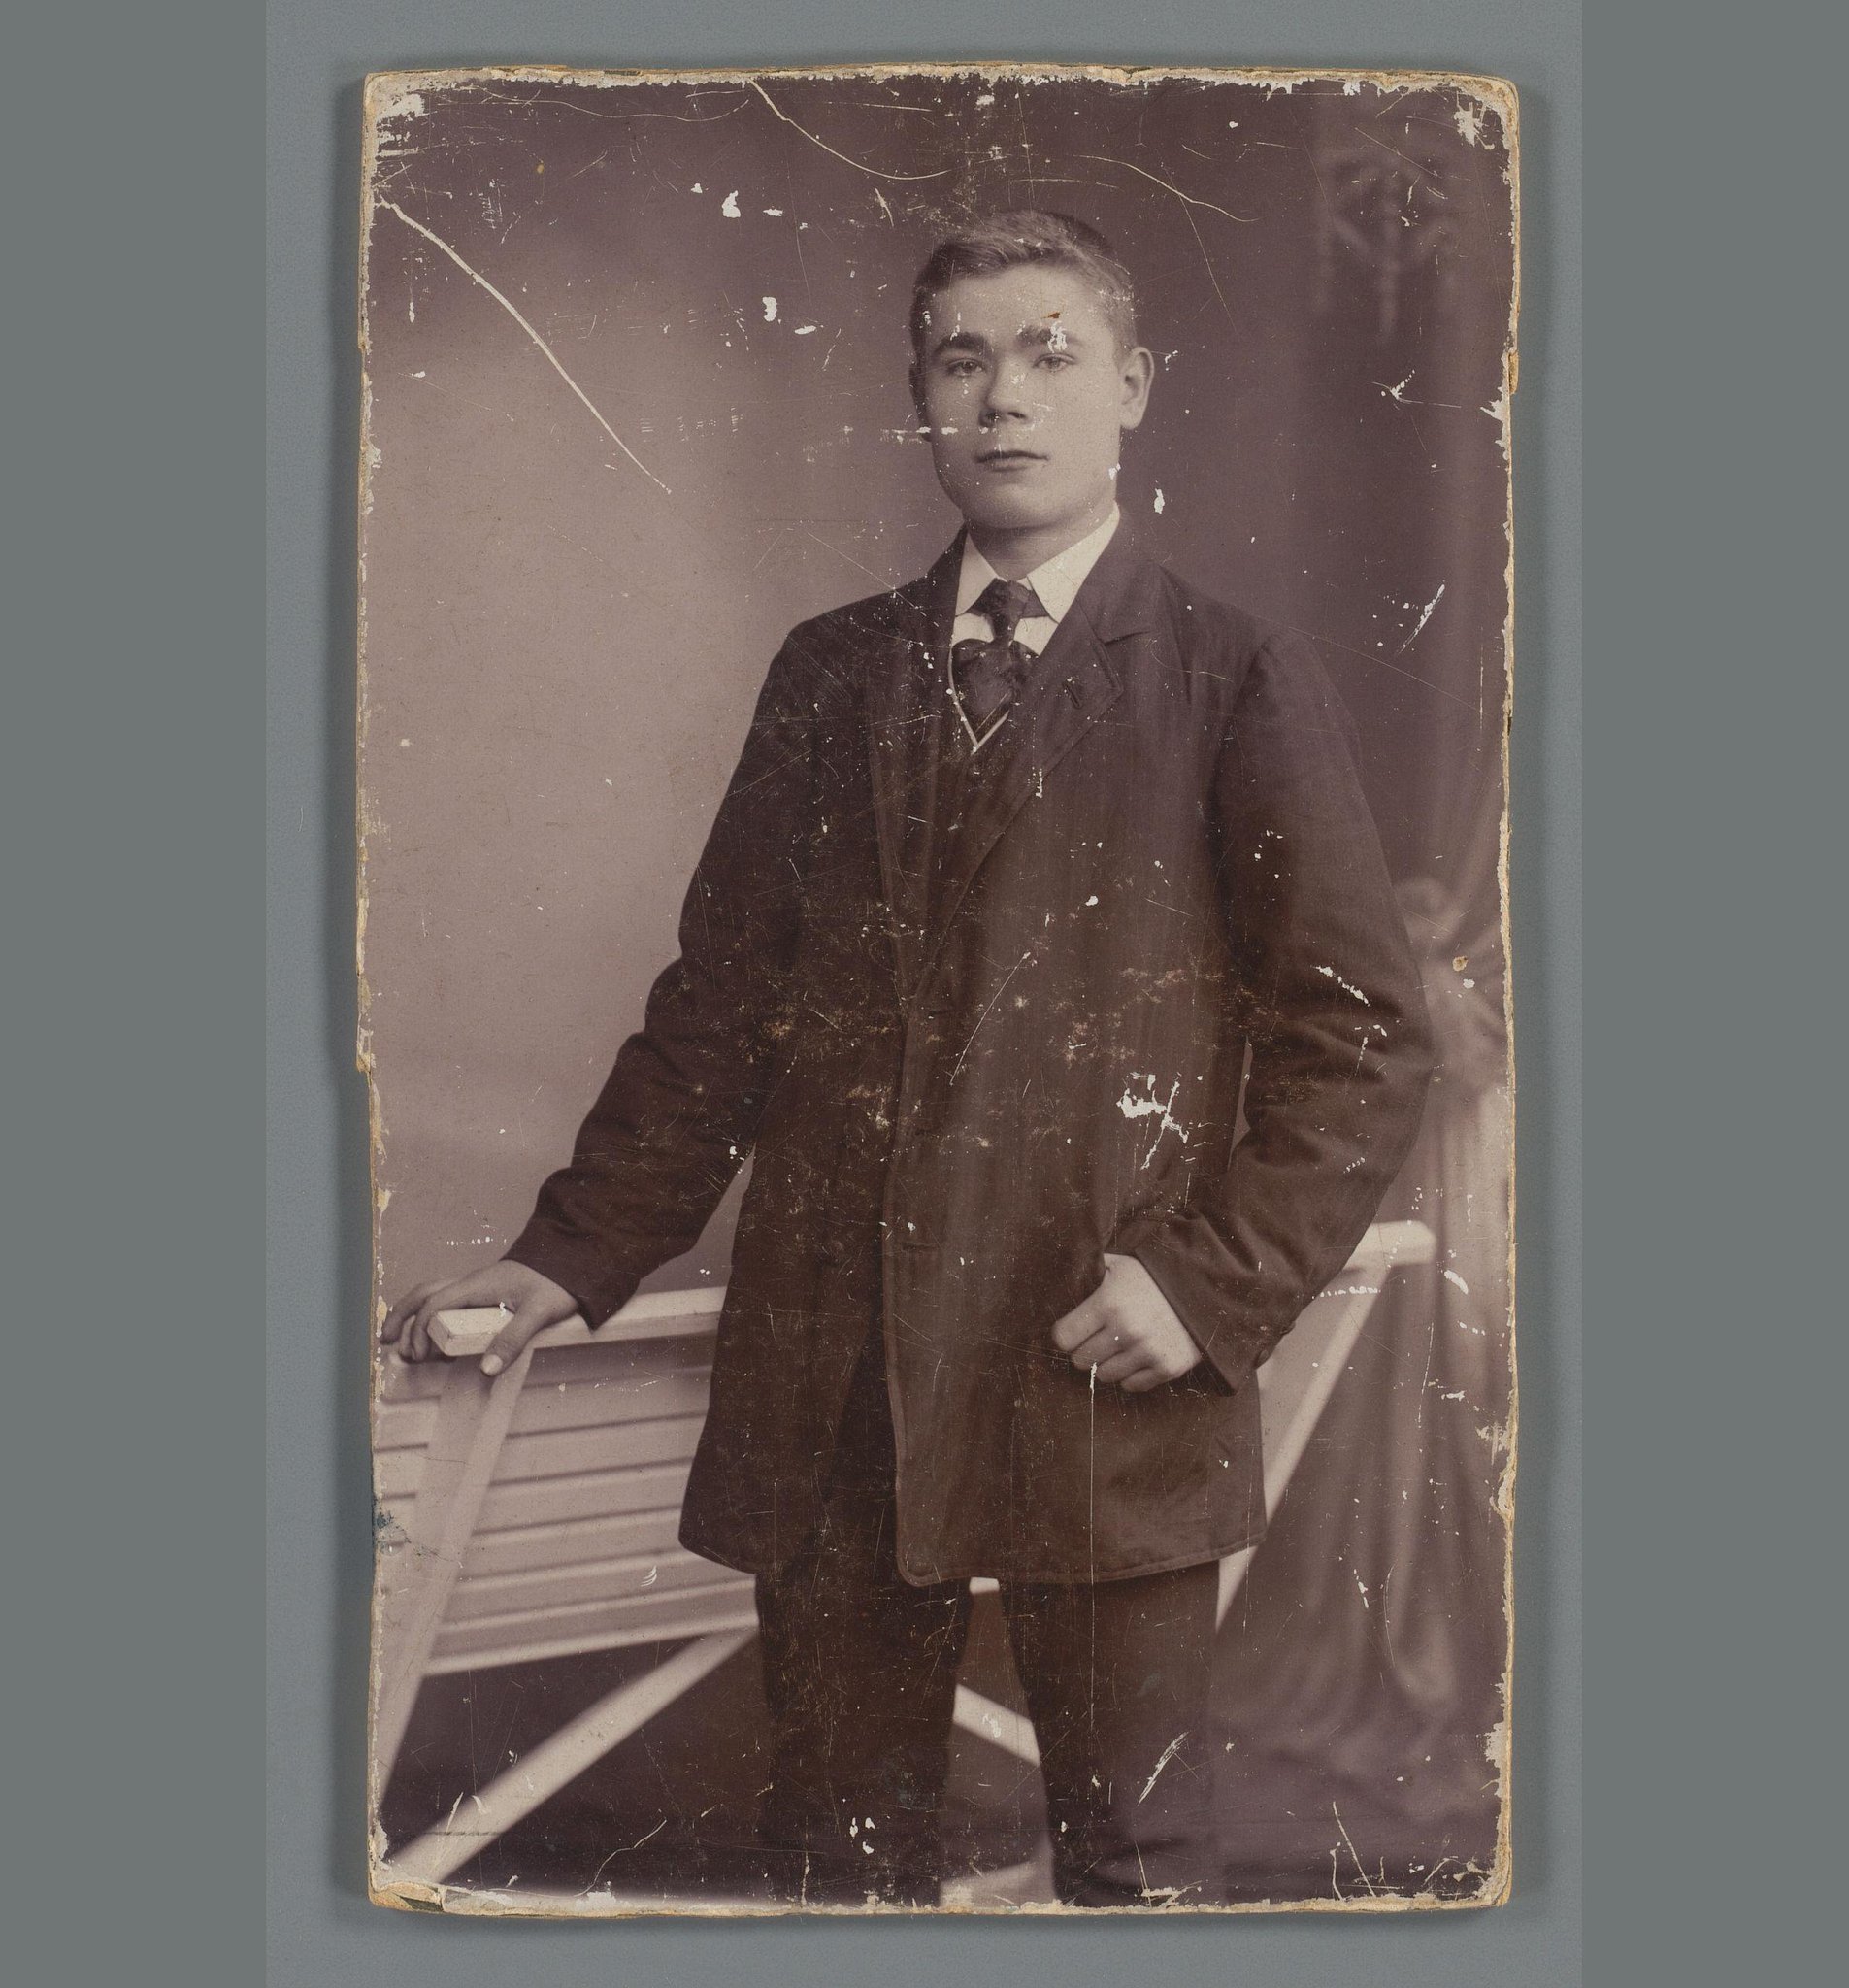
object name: photograph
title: Portret van een onbekende jongeman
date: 1912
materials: paper, cardboard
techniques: collodion silver print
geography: leeuwarden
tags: historical persons not known by name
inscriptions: inscription: ‘1912/ Fotogr. Atelier/ de Jong/ Leeuwarden/ Nieuwestad 53./ Sneek kl: Zand./ Vergrootingen naar elk portret/ De plaat blijft voor nabestelling/ bewaard.’